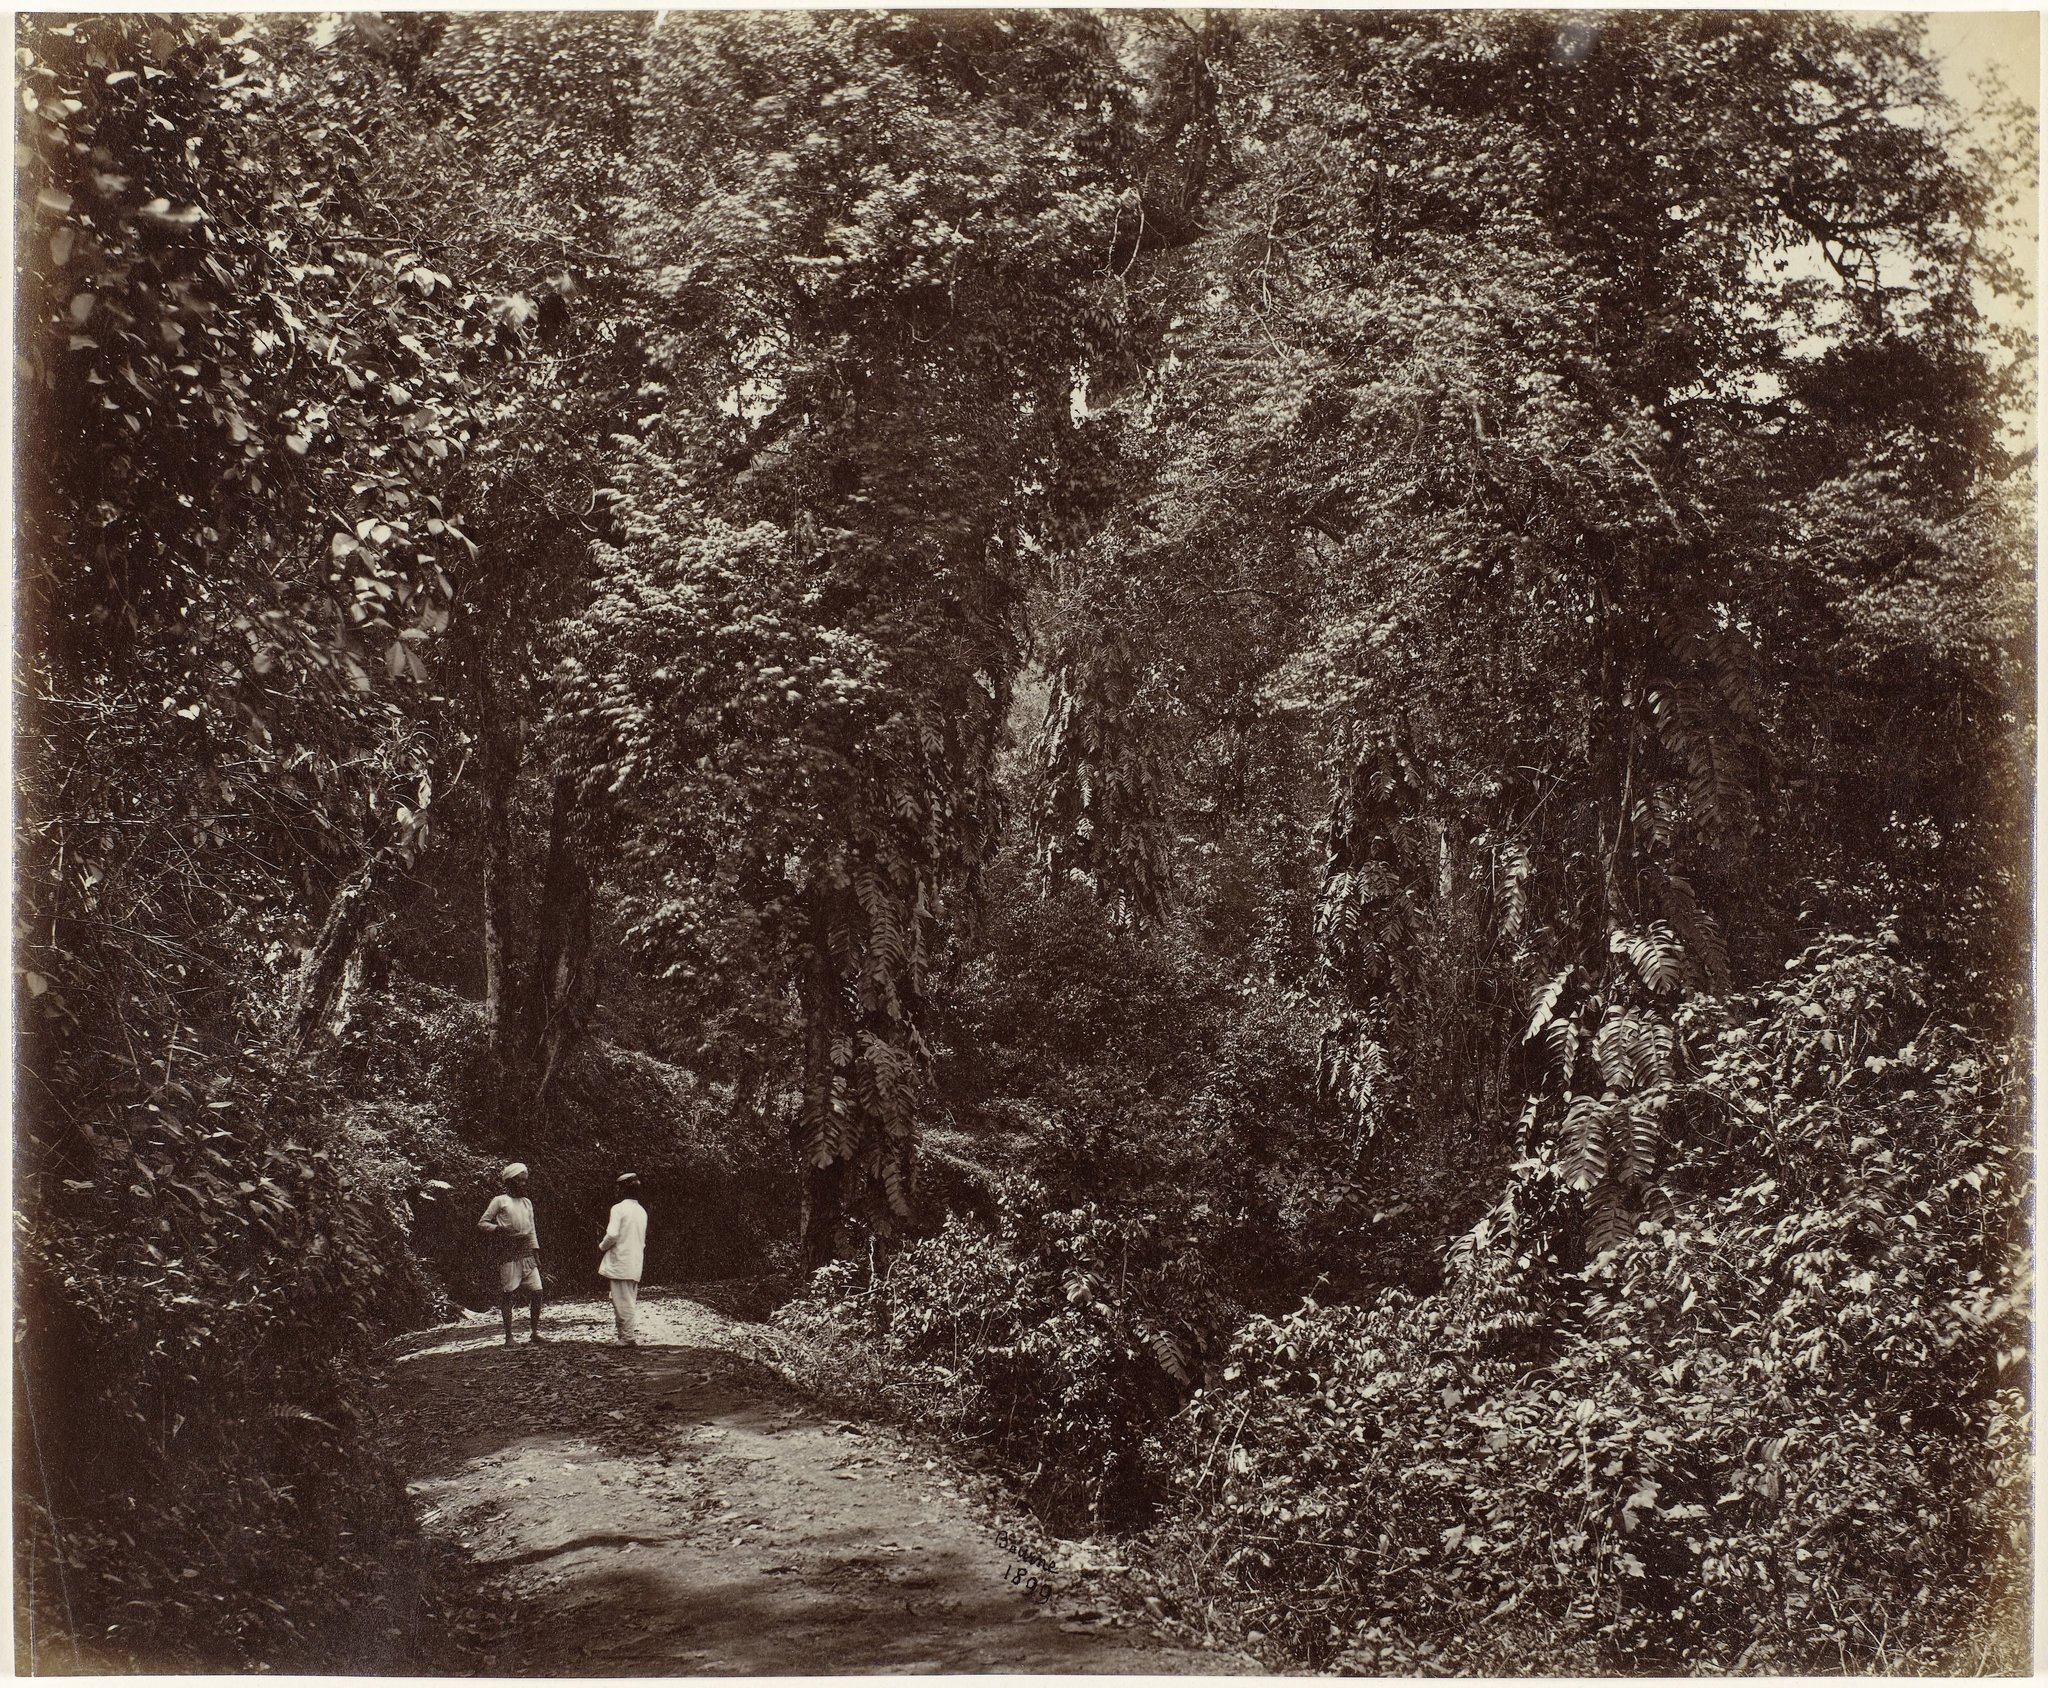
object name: photograph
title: Forest trail towards Tukvar, Darleeling, West Bengal, India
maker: samuel bourne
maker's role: fotograaf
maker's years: 1834-1912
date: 1868-1869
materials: paper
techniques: albumen print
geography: darjeeling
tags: forest path or lane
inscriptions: number: ‘1899’, number: ‘Bourne’, number: ‘1899’